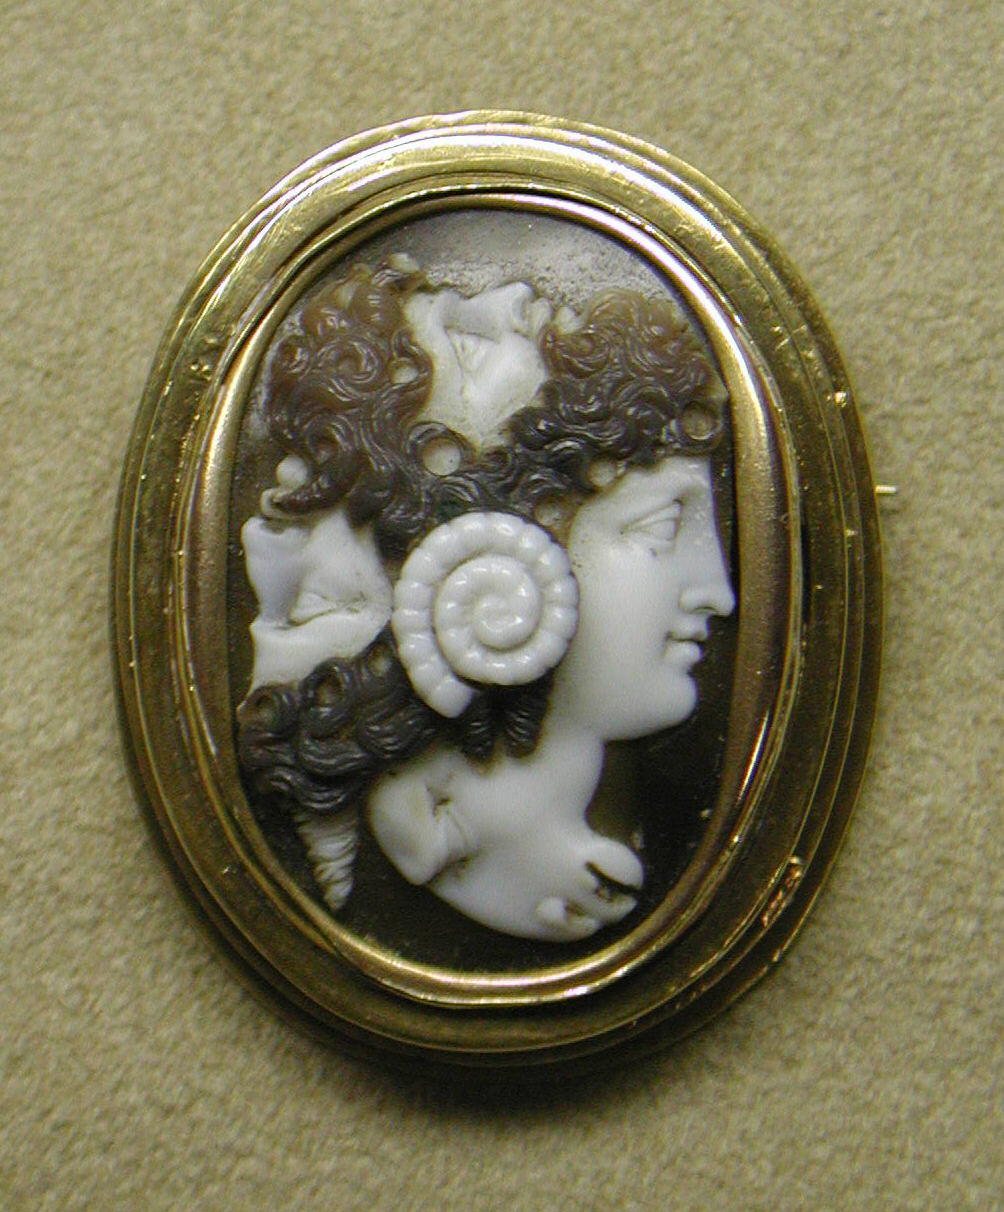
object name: cameo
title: Gryllos: conjoined heads of a youth, a bearded man, a satyr, and a ram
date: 1767-1833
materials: gold, onyx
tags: heads,men,satyrs,rams